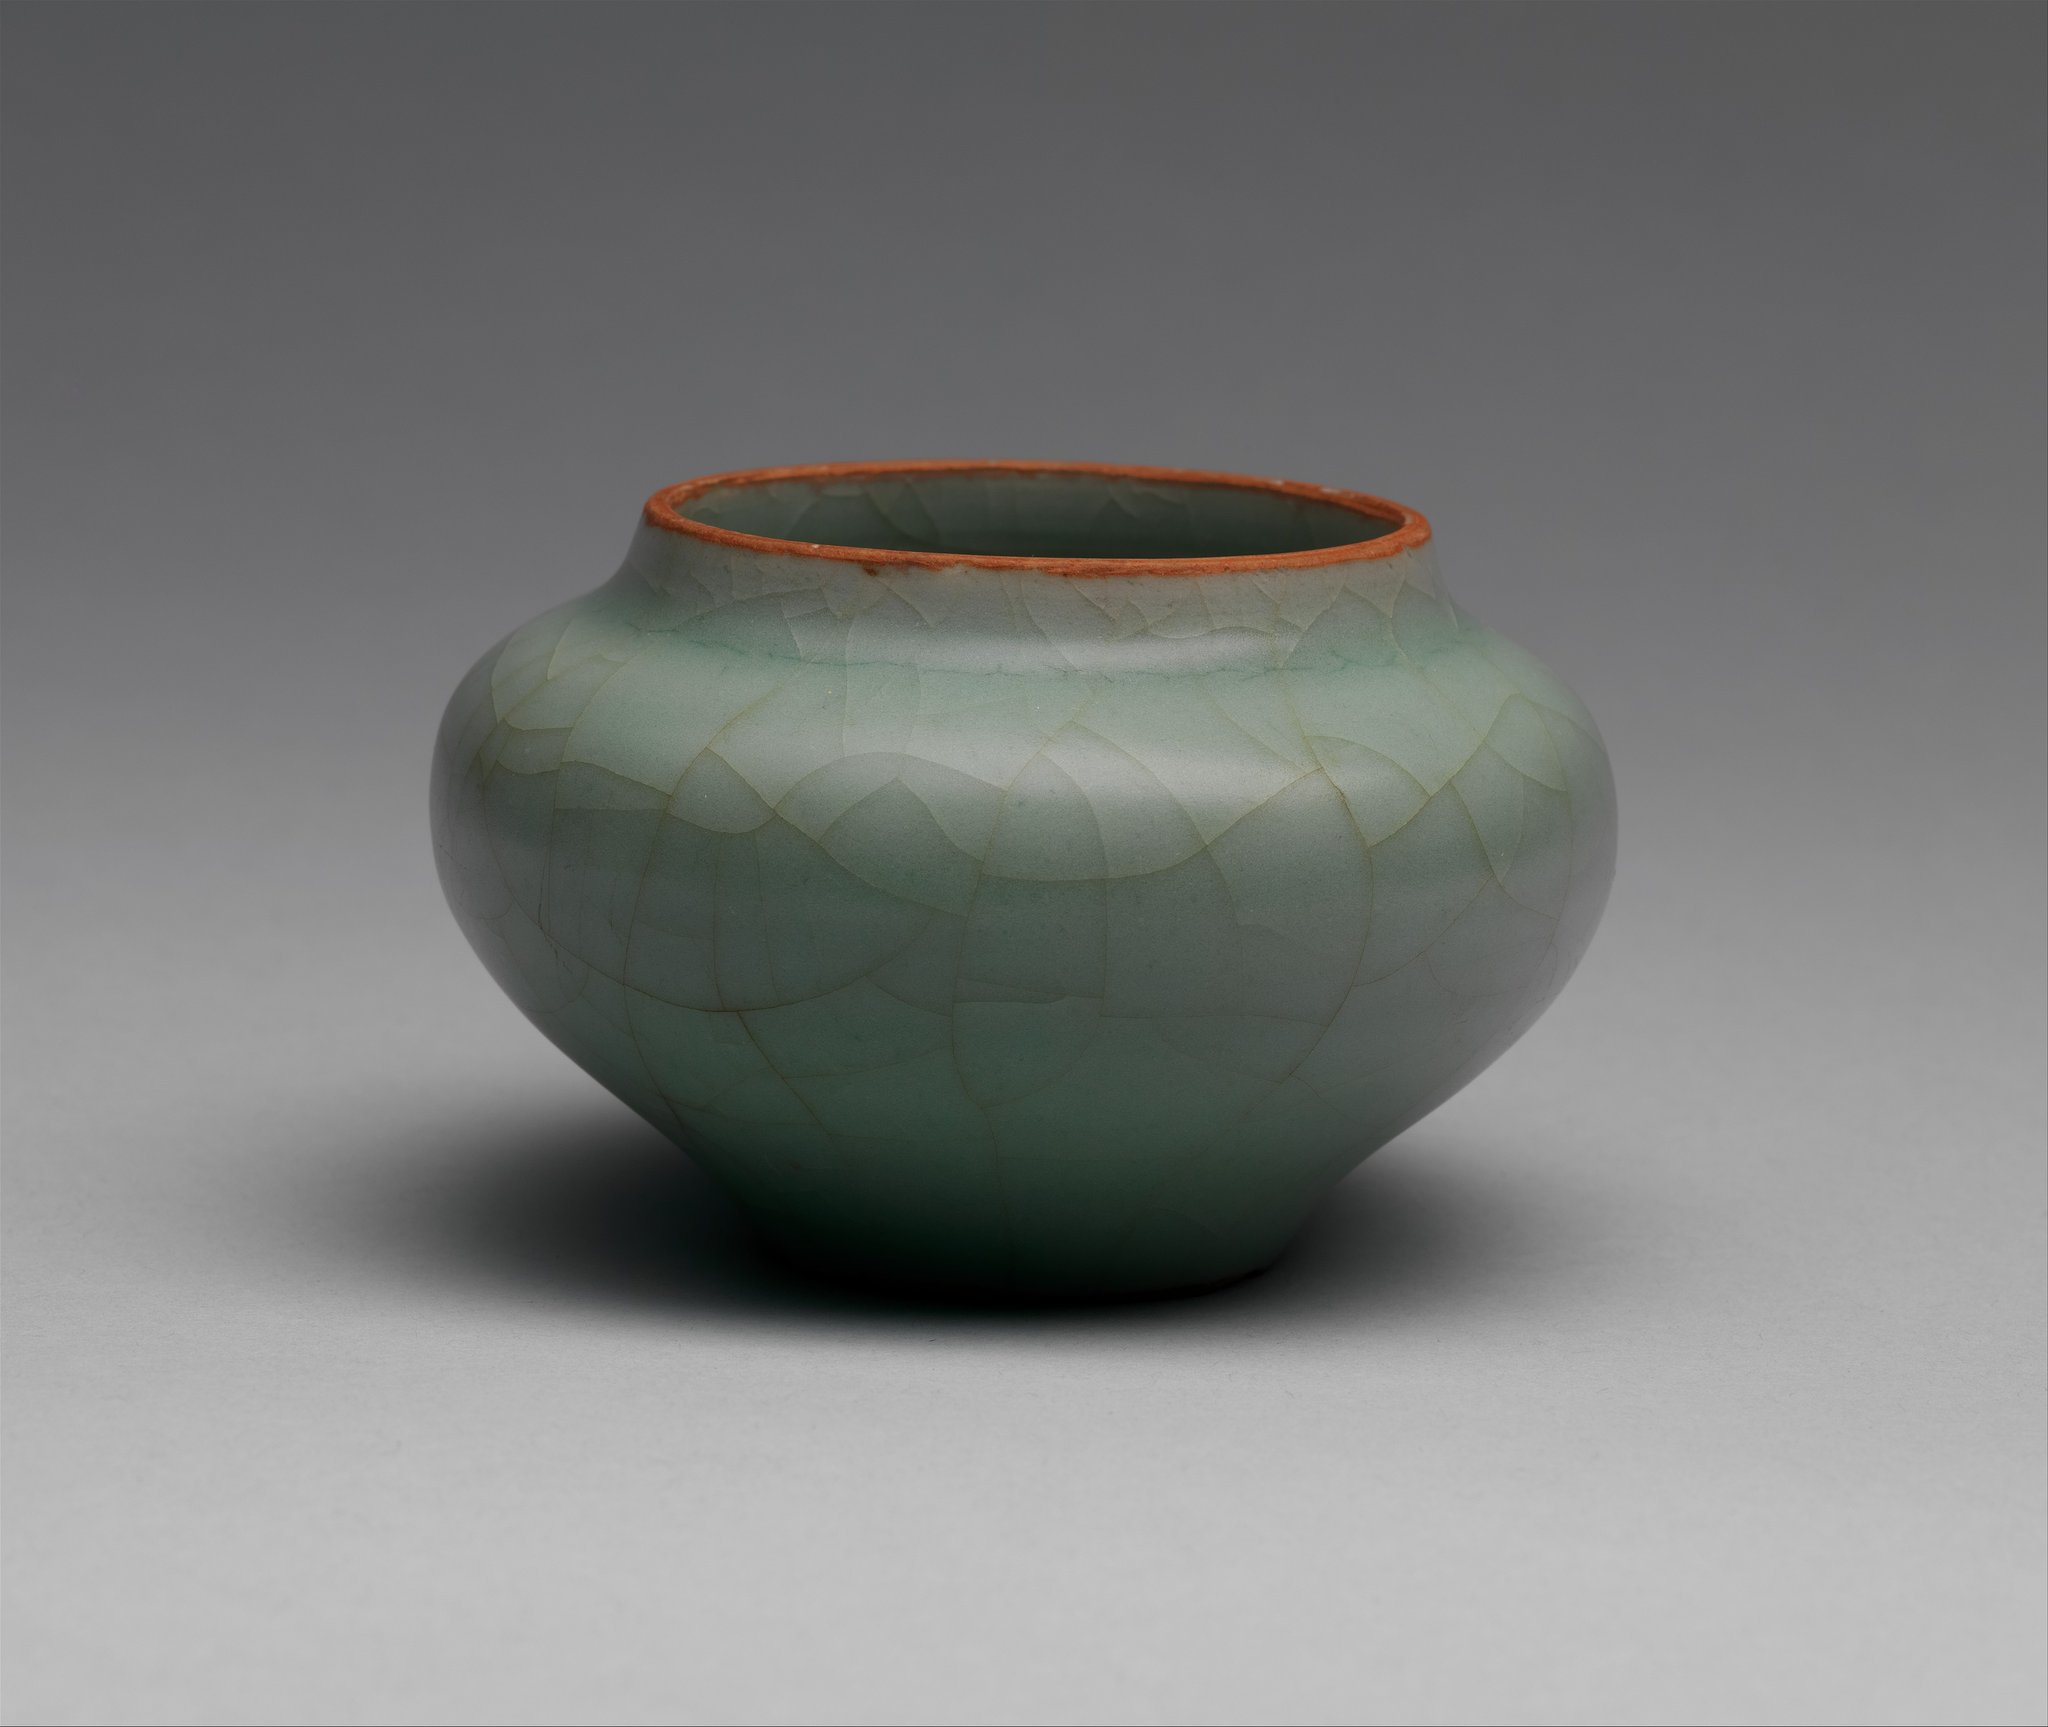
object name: jar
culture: chinese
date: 960-1279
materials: ceramic glaze, glaze, stoneware